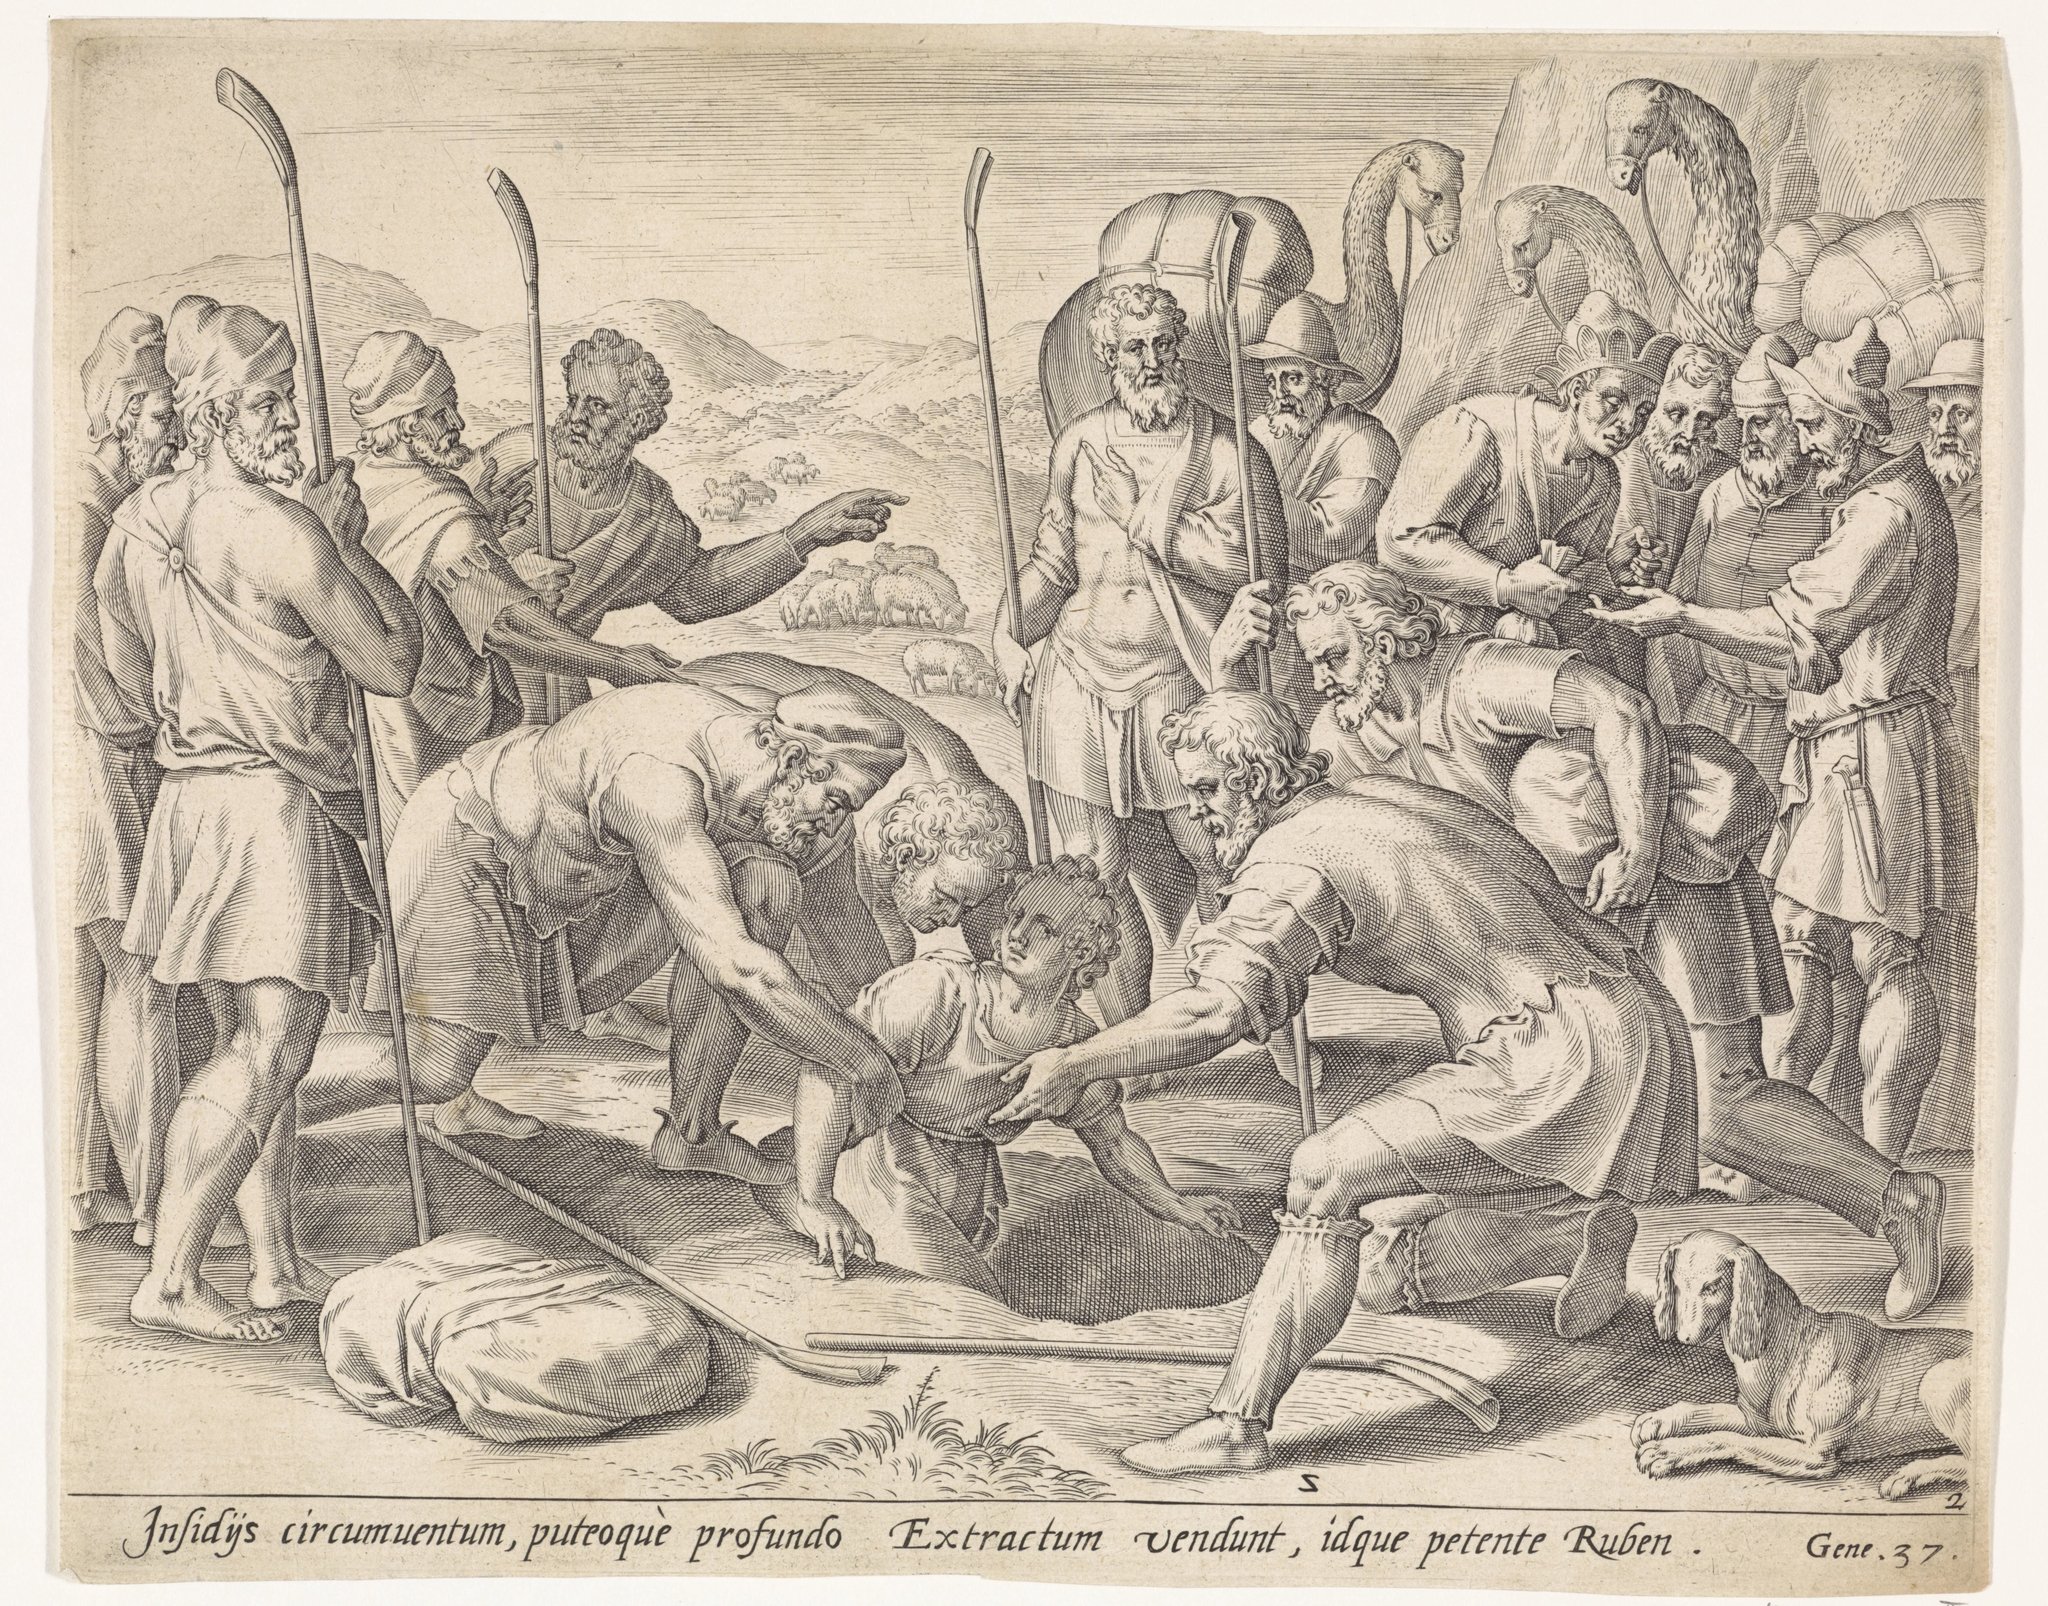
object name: print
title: Jozef door zijn broers verkocht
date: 1579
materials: paper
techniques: engraving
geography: amsterdam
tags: joseph is pulled out of the pit, joseph is sold for twenty pieces of silver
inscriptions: collector's mark: Lugt 2228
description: Prent gebruikt in: Theatrum biblicum : hoc est historiae sacrae veteris et novi testamenti tabulis aeneis expressae. Opus praesentatissimorum huius ac superioris seculi pictorum atque sculptorum, summo studio conquisitum et in lucem editum. Amsterdam: Claes Jansz. Visscher, 1643.